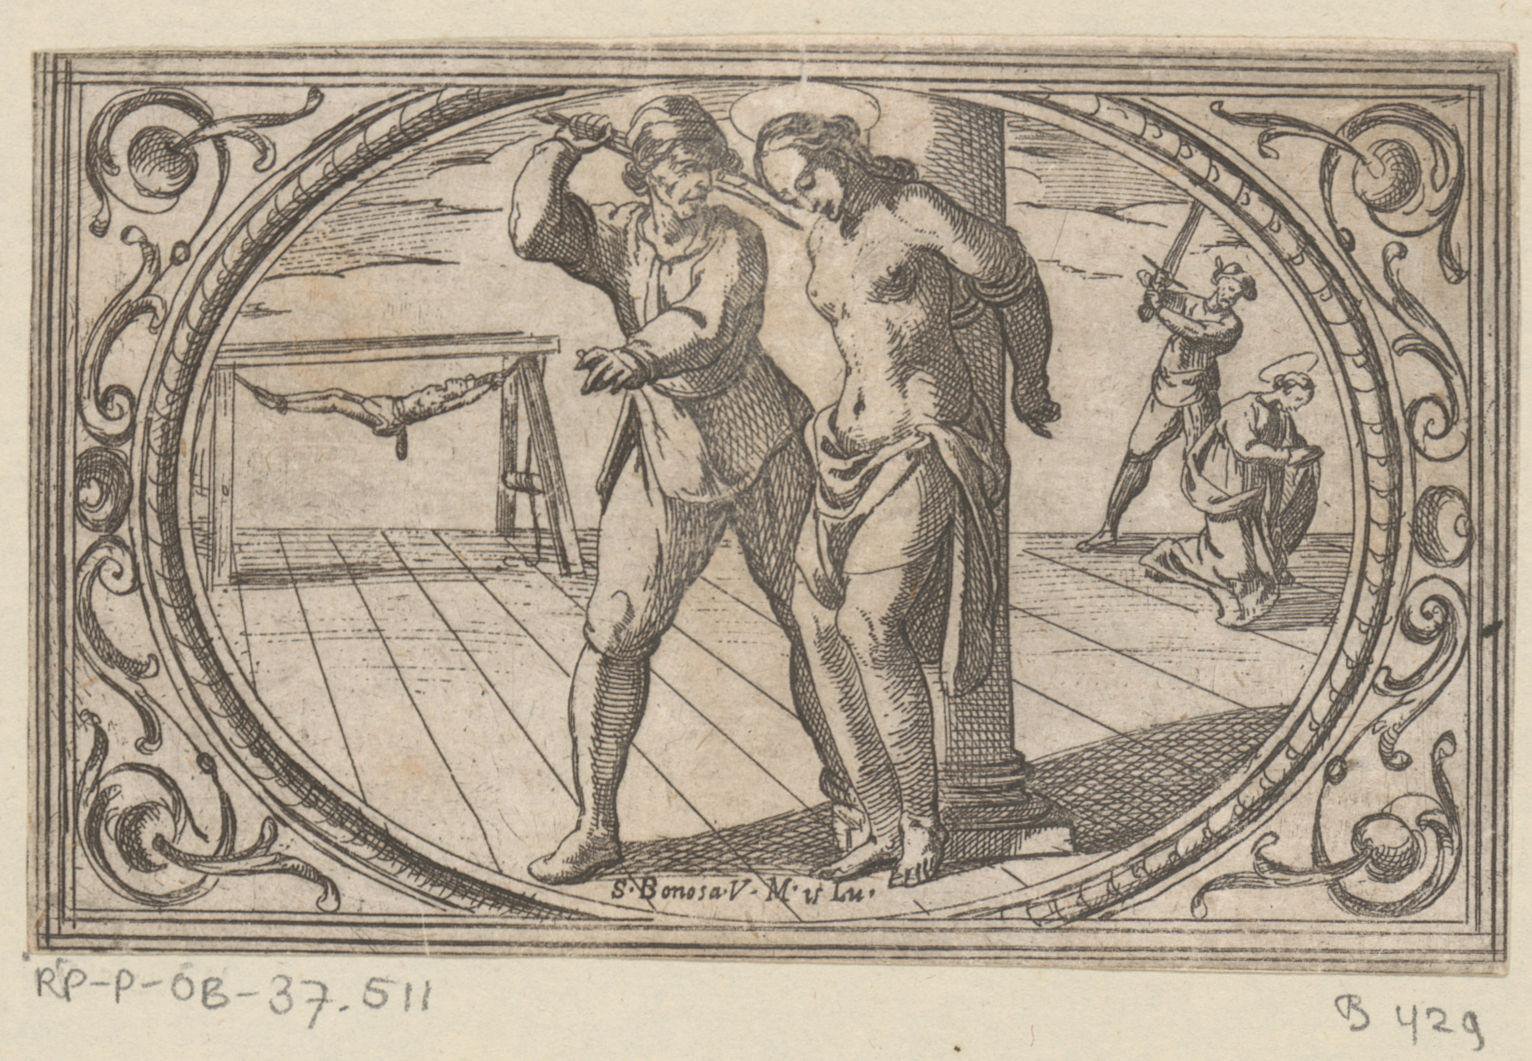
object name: print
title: Romeinse martelaressen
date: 1565-1630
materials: paper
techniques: etching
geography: rome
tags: martyr(s) (often with palm-branches) - qq - female martyr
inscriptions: collector's mark: Lugt 240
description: Deze prent maakt deel uit van een reeks van 73 prenten (+ titelprent) met voorstellingen van Romeinse martelaressen.